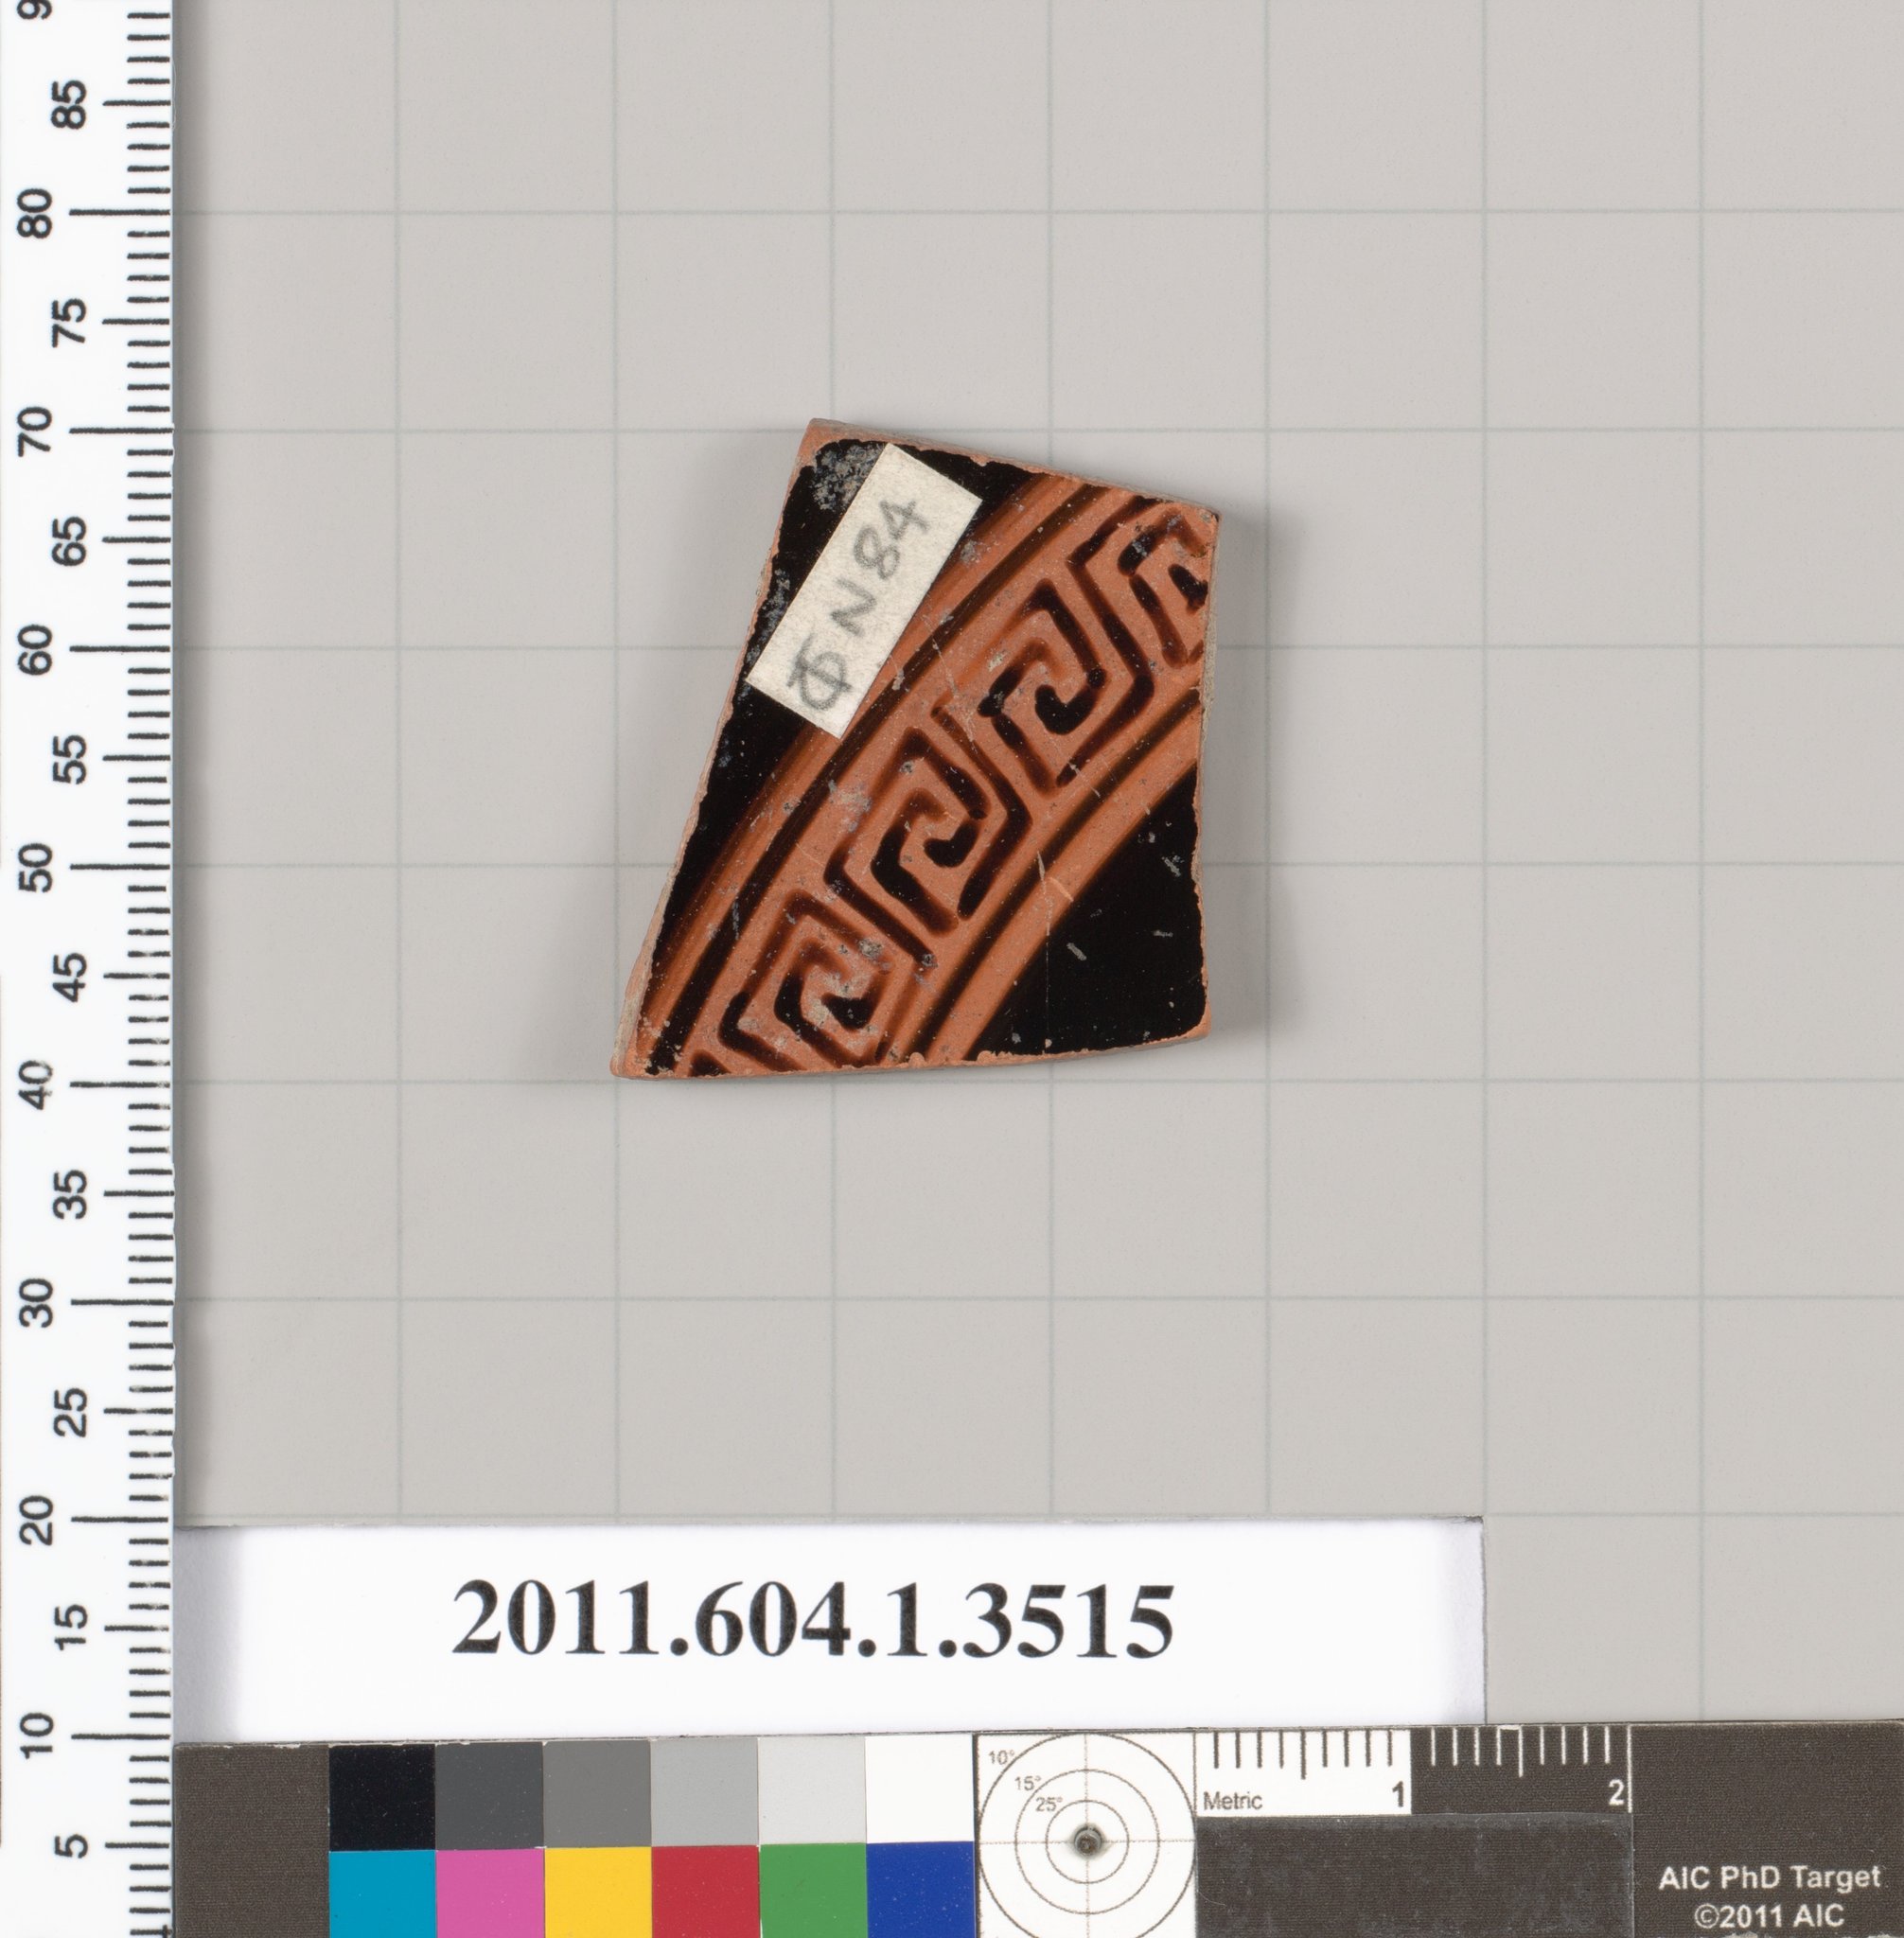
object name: kylix fragment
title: Terracotta fragment of a kylix (drinking cup)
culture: greek, attic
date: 500-476 BCE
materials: terracotta